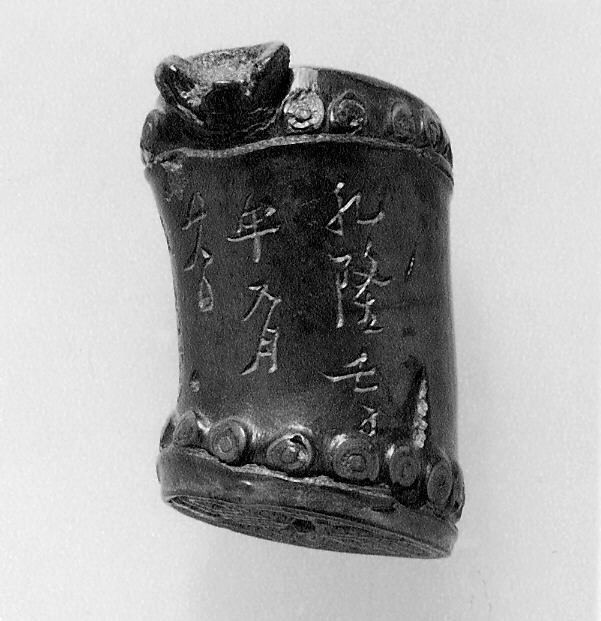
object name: seal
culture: chinese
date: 1736-1795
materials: bamboo